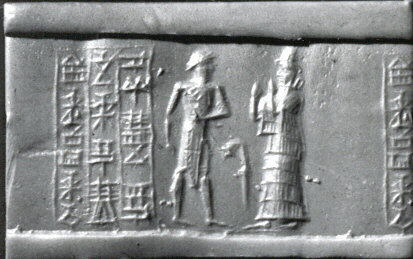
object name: cylinder seal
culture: babylonian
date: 1900-1501 BCE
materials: mineral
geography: mesopotamia